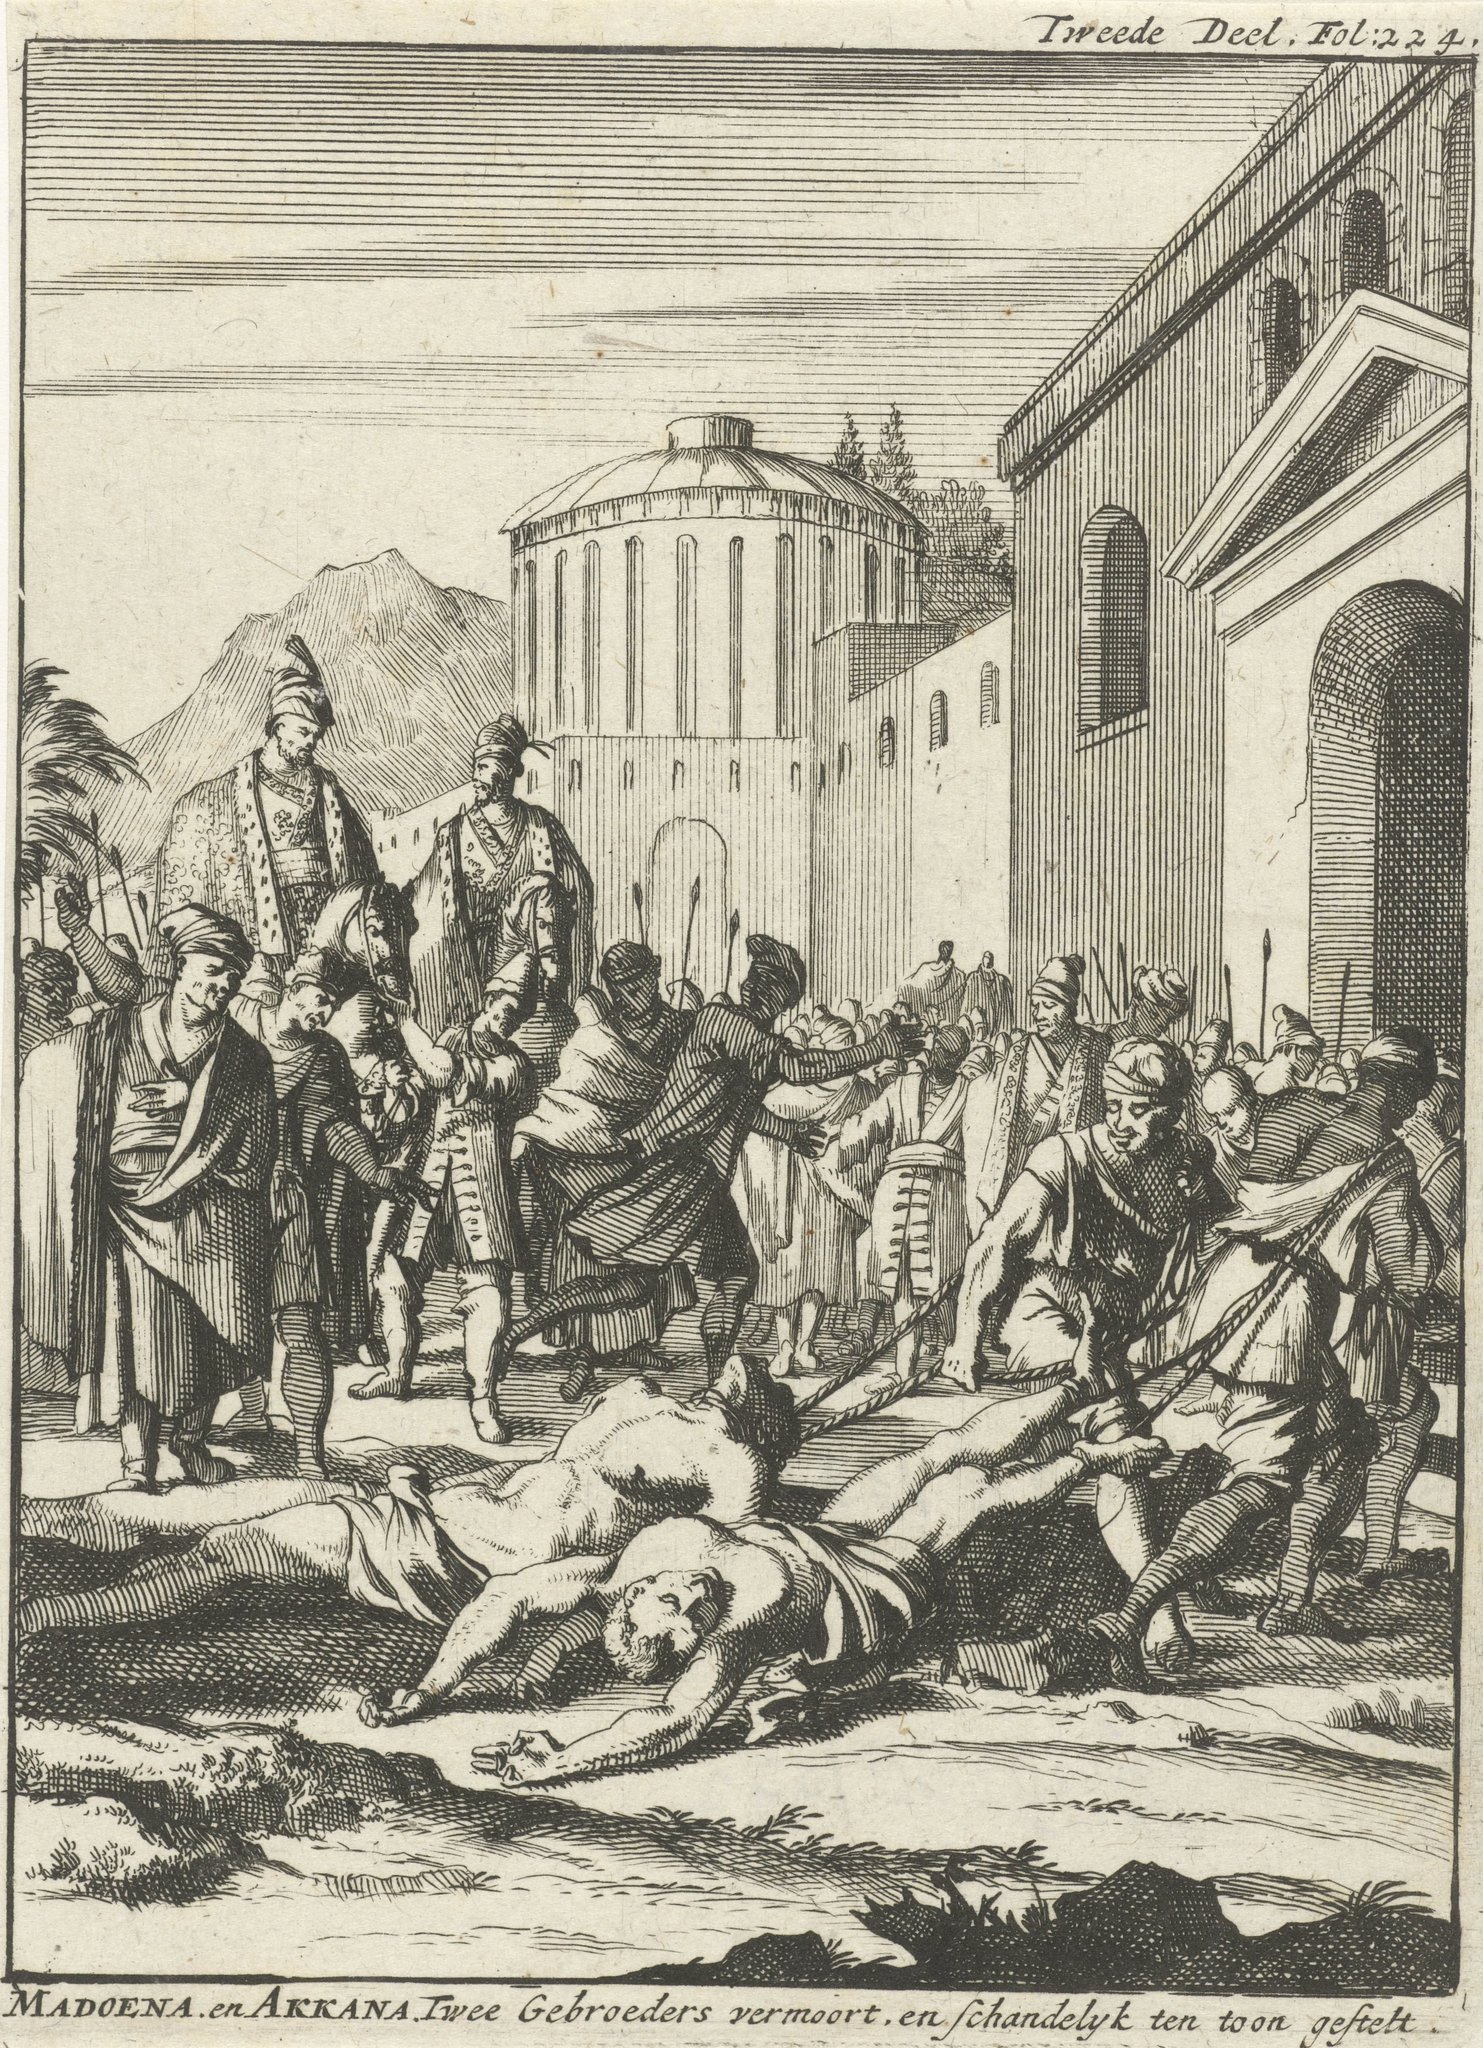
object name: book illustration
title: Twee vermoorde broers worden, voortgetrokken met touwen, aan het publiek getoond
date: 1693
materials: paper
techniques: etching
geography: amsterdam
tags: violent death ~ maltreatment, torture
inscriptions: collector's mark: Lugt 2228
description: Illustratie uit: Havart, Daniël. Op- en ondergang van Cormandel, 2 delen. Amsterdam: Jan Claesz ten Hoorn, 1693.